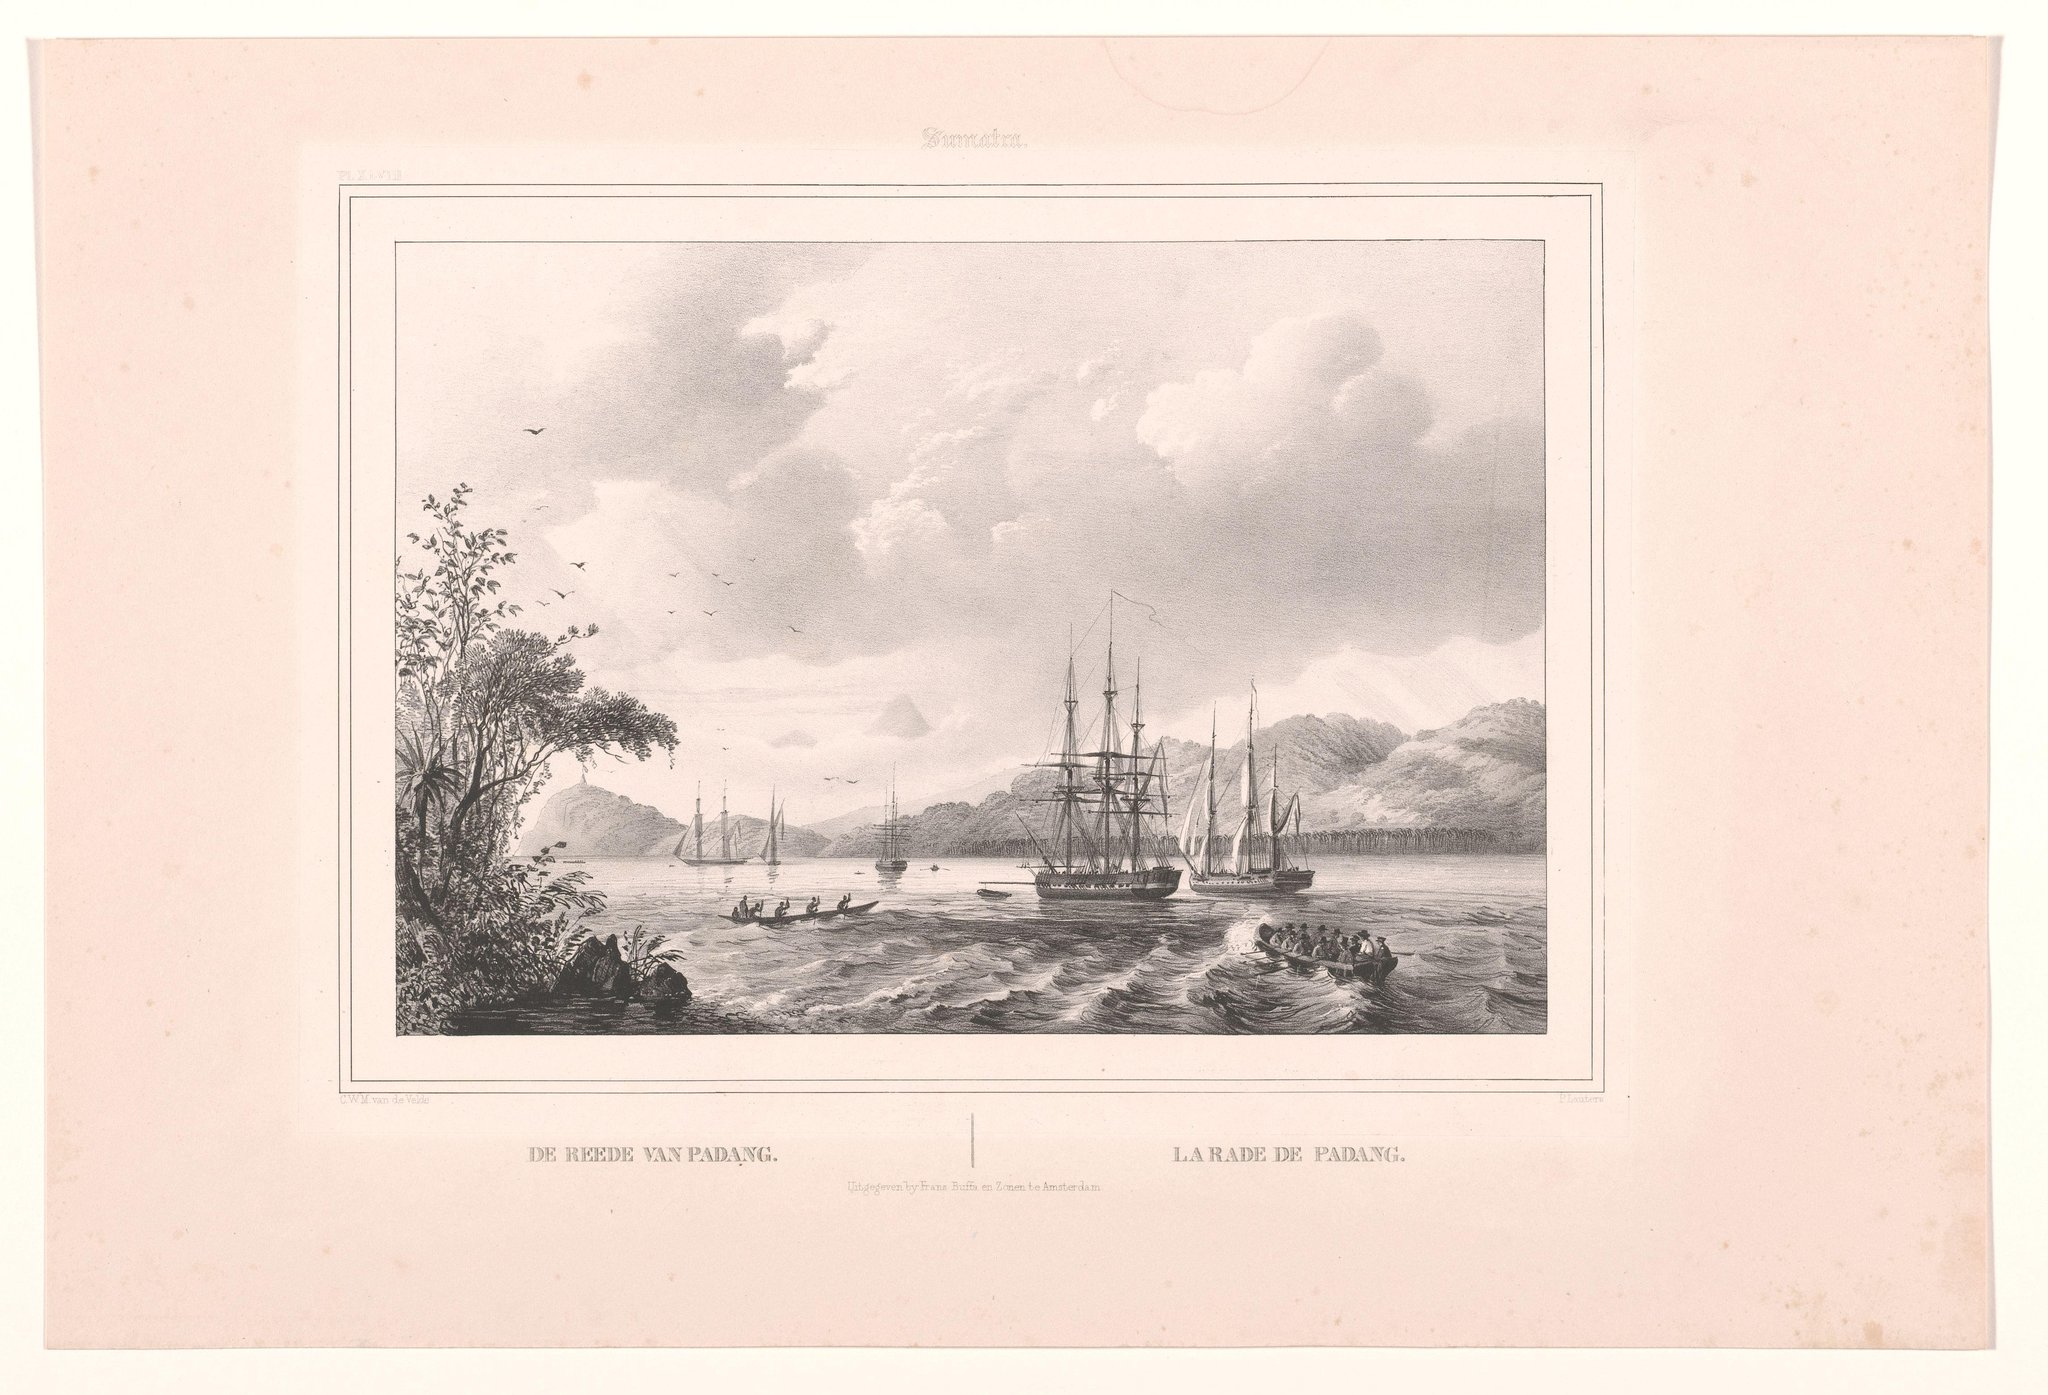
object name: print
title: Gezigten uit Neêrlands Indië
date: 1843-1845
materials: paper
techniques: lithograph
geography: amsterdam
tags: gulf, bay, sailing-ship, sailing-boat, sailing-ship, sailing-boat (+ loading)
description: Zeilschepen liggen voor anker in de baai. Twee volle roeiboten varen naar de schepen toe. Genummerd linksboven: Pl. XLVIII. De prent maakt deel uit van een omslag met zeven bladen.